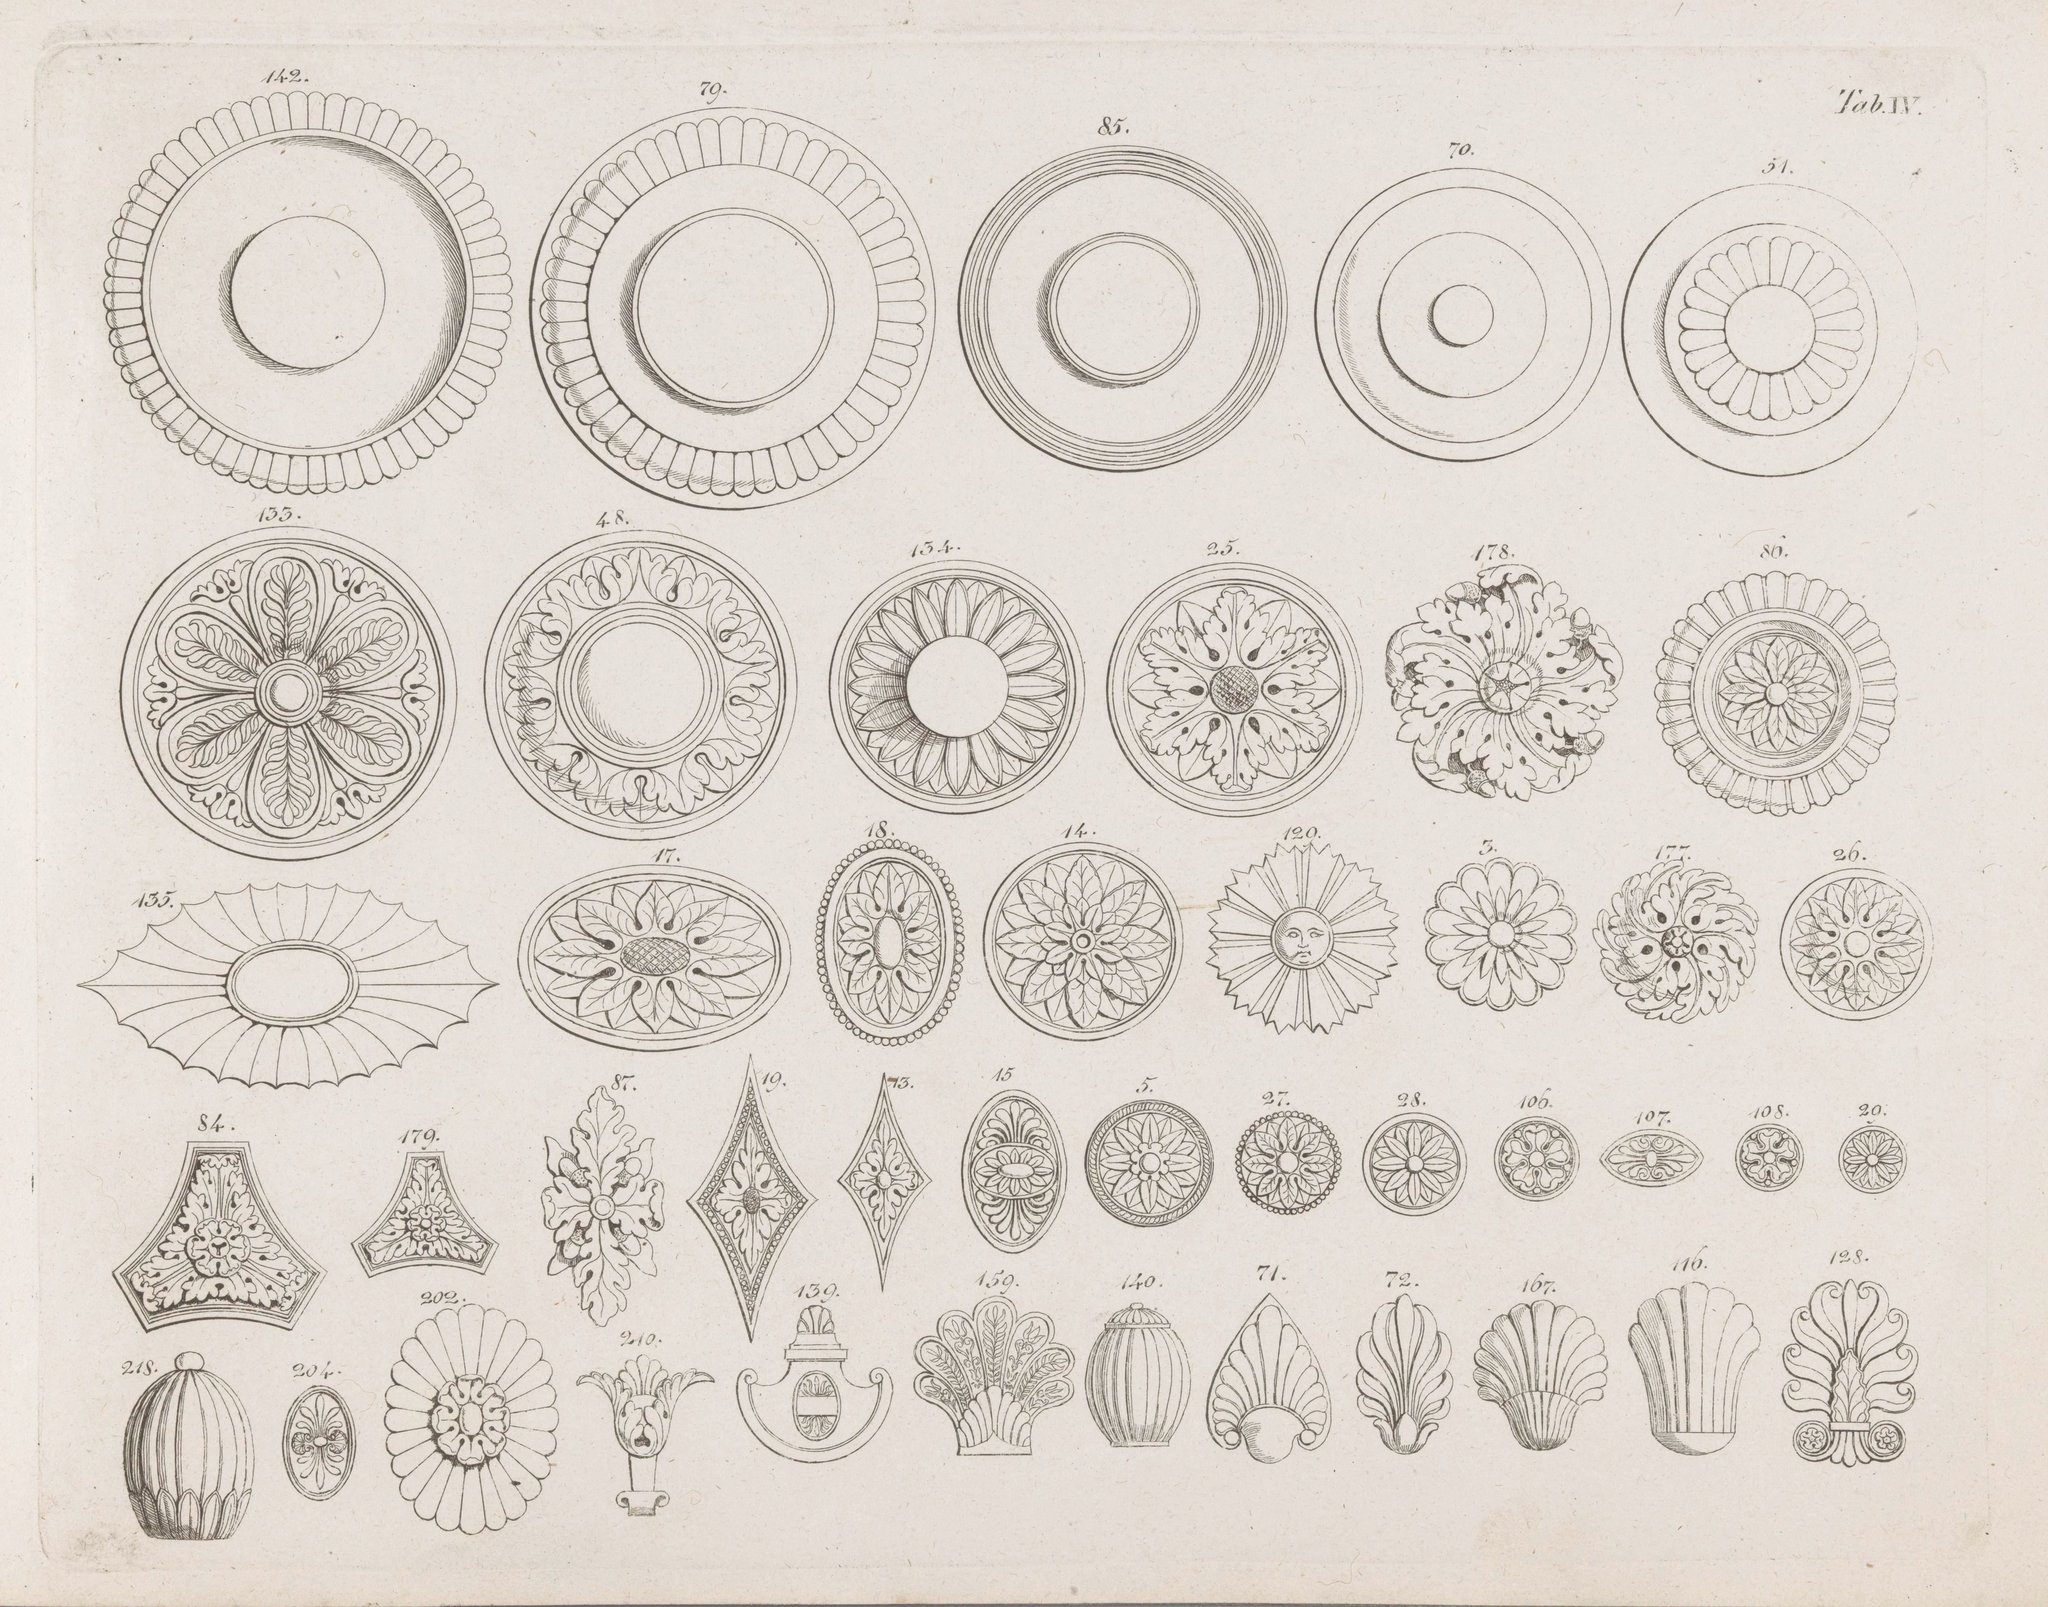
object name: album leaf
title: Ornamenten en medaillons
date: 1817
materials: paper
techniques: etching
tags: ornaments ~ art, ornament ~ medallion, ornament derived from plant forms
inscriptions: collector's mark: Lugt 2228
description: Ontwerpen voor ornamenten en medaillons met bladmotieven. Alle objecten zijn genummerd. Prent maakt deel uit van een album met een serie van zes ornamenten.